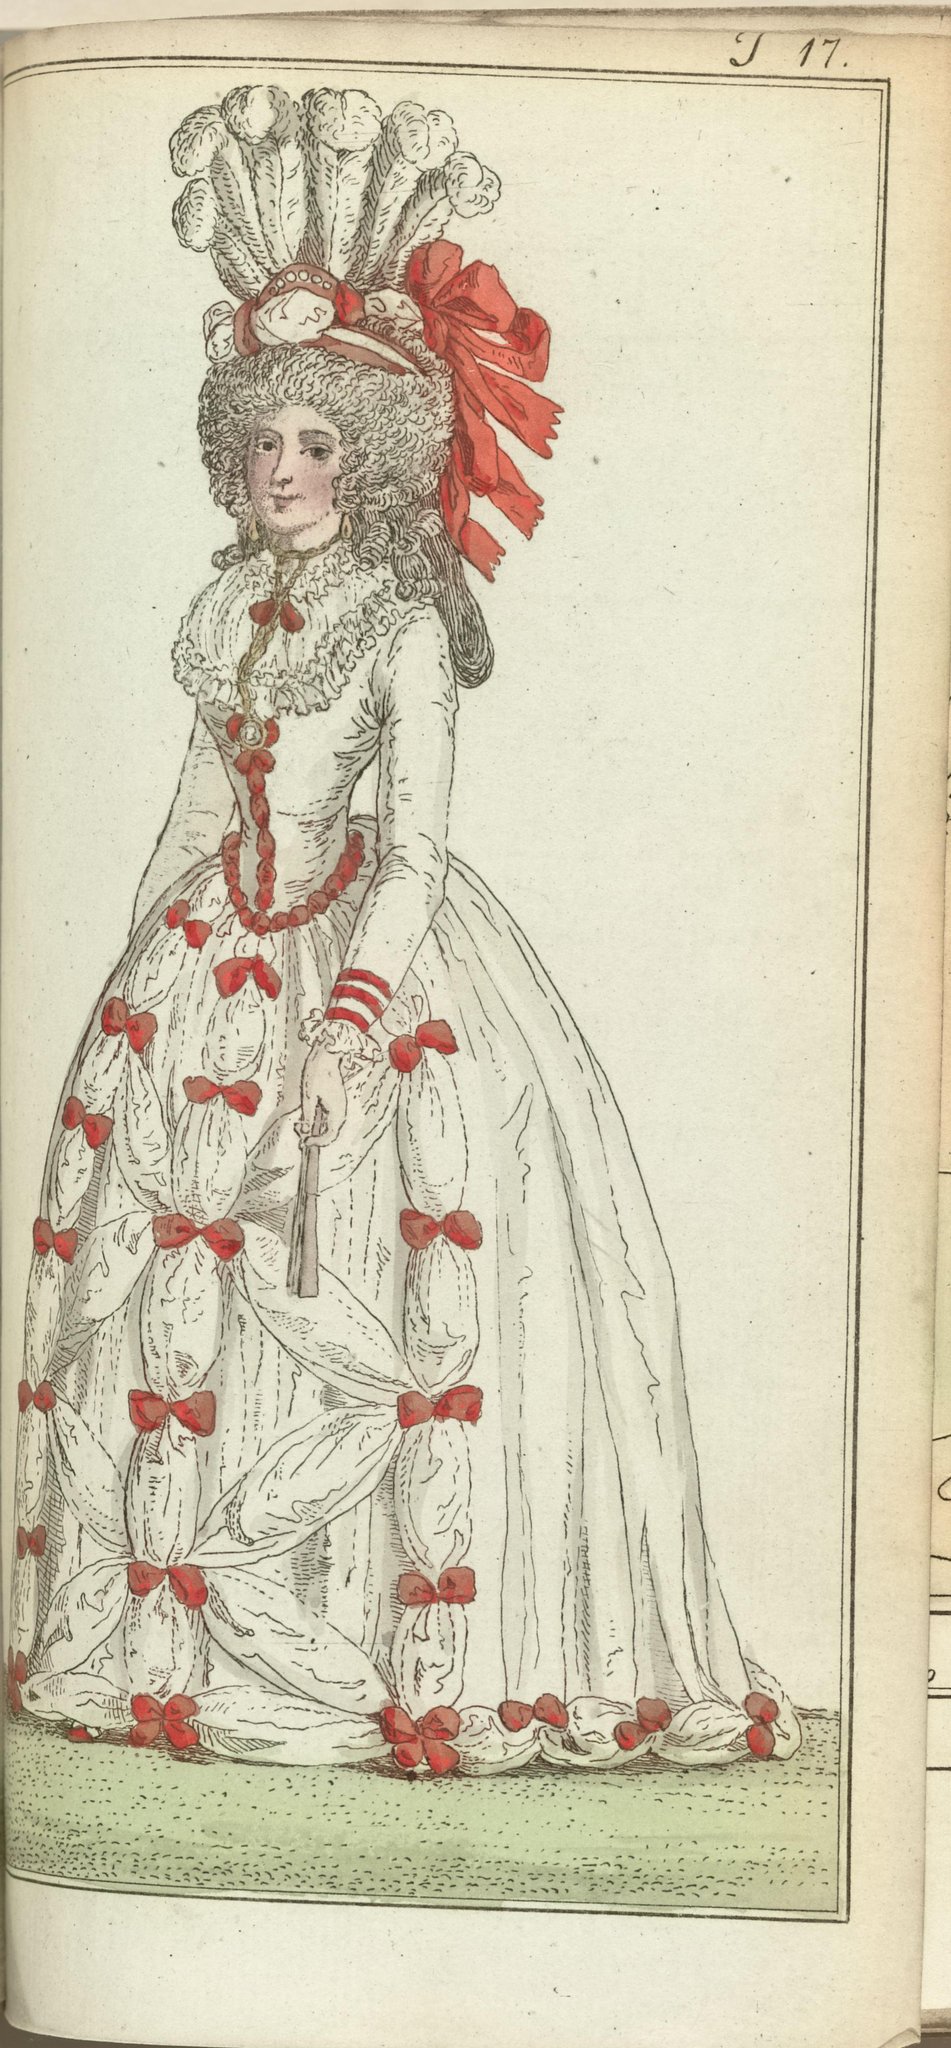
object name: magazine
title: Journal des Luxus und der Moden 1790, Band V, T.17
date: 1790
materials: paper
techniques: etching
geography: weimar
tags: fashion plates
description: Prent uit het modetijdschrift Journal des Luxus und der Moden, uitgegeven door Friedrich Justin Bertuch en Georg Melchior Kraus, Weimar, 1786-1826.